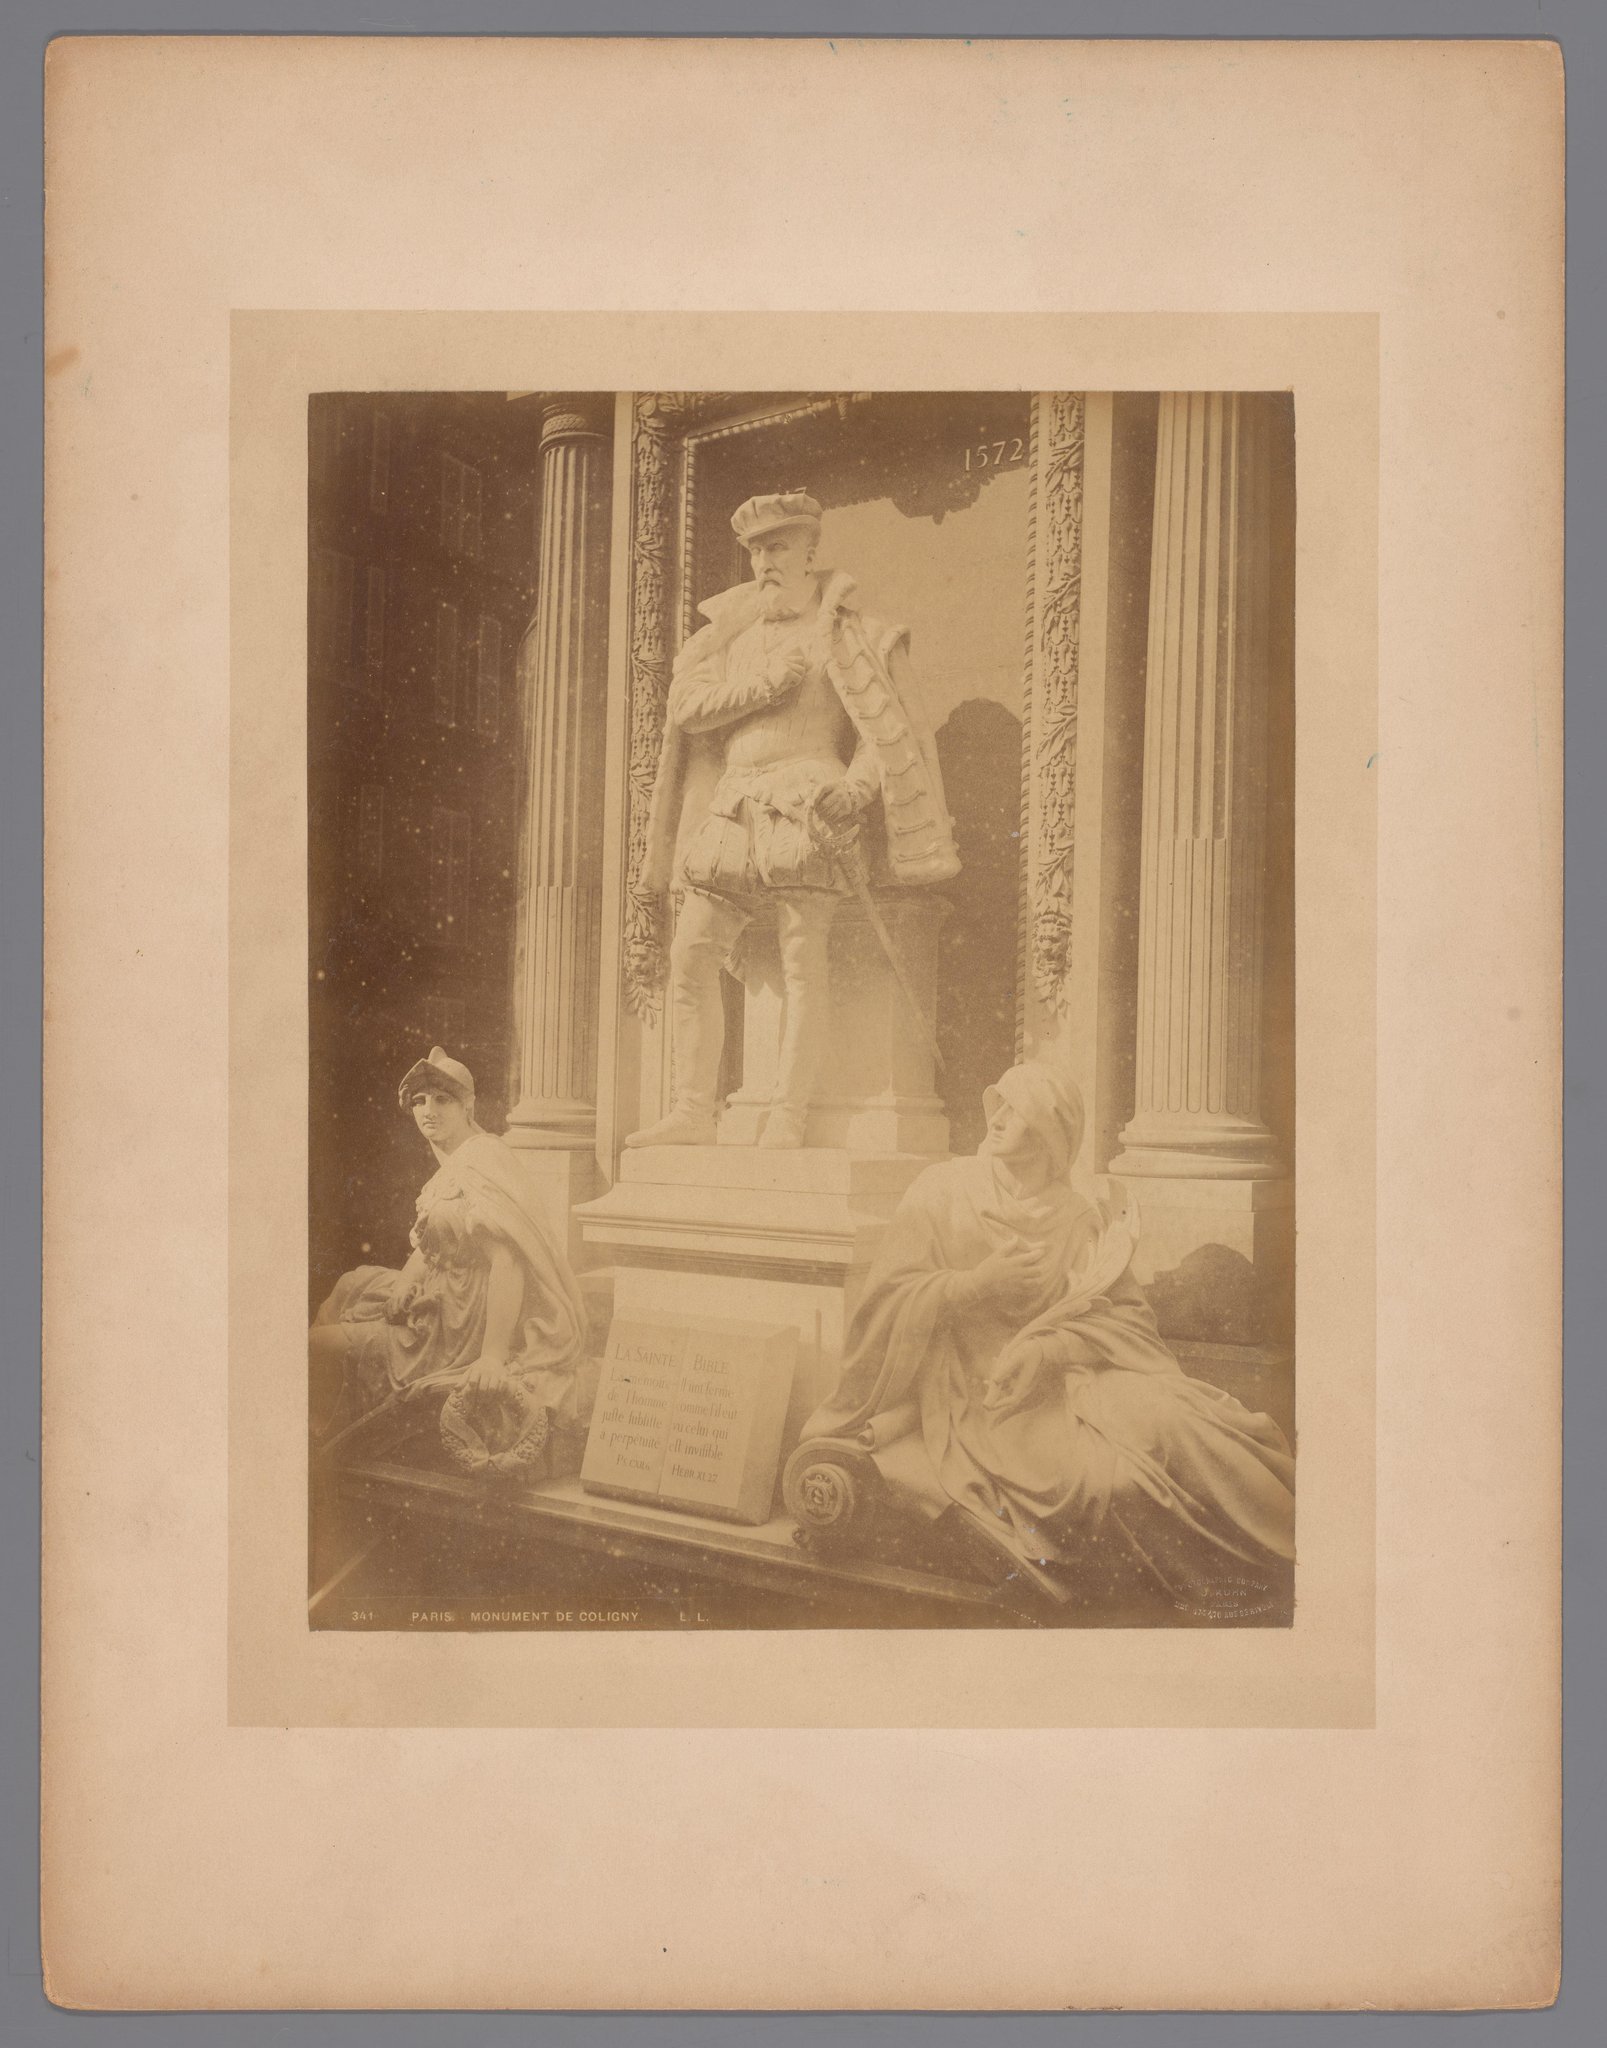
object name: photograph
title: Monument de Coligny, Parijs, Frankrijk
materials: cardboard, paper, photographic support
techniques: albumen print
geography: paris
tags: paris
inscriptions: inscription: ‘341 PARIS MONUMENT DECOLIGNY’, inscription: ‘L.L.’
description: Dit monument voor Gaspard de Coligny (1519-1572) bevindt zich aan de rue de Rivoli in Parijs en werd op 24 juli 1889 onthuld.